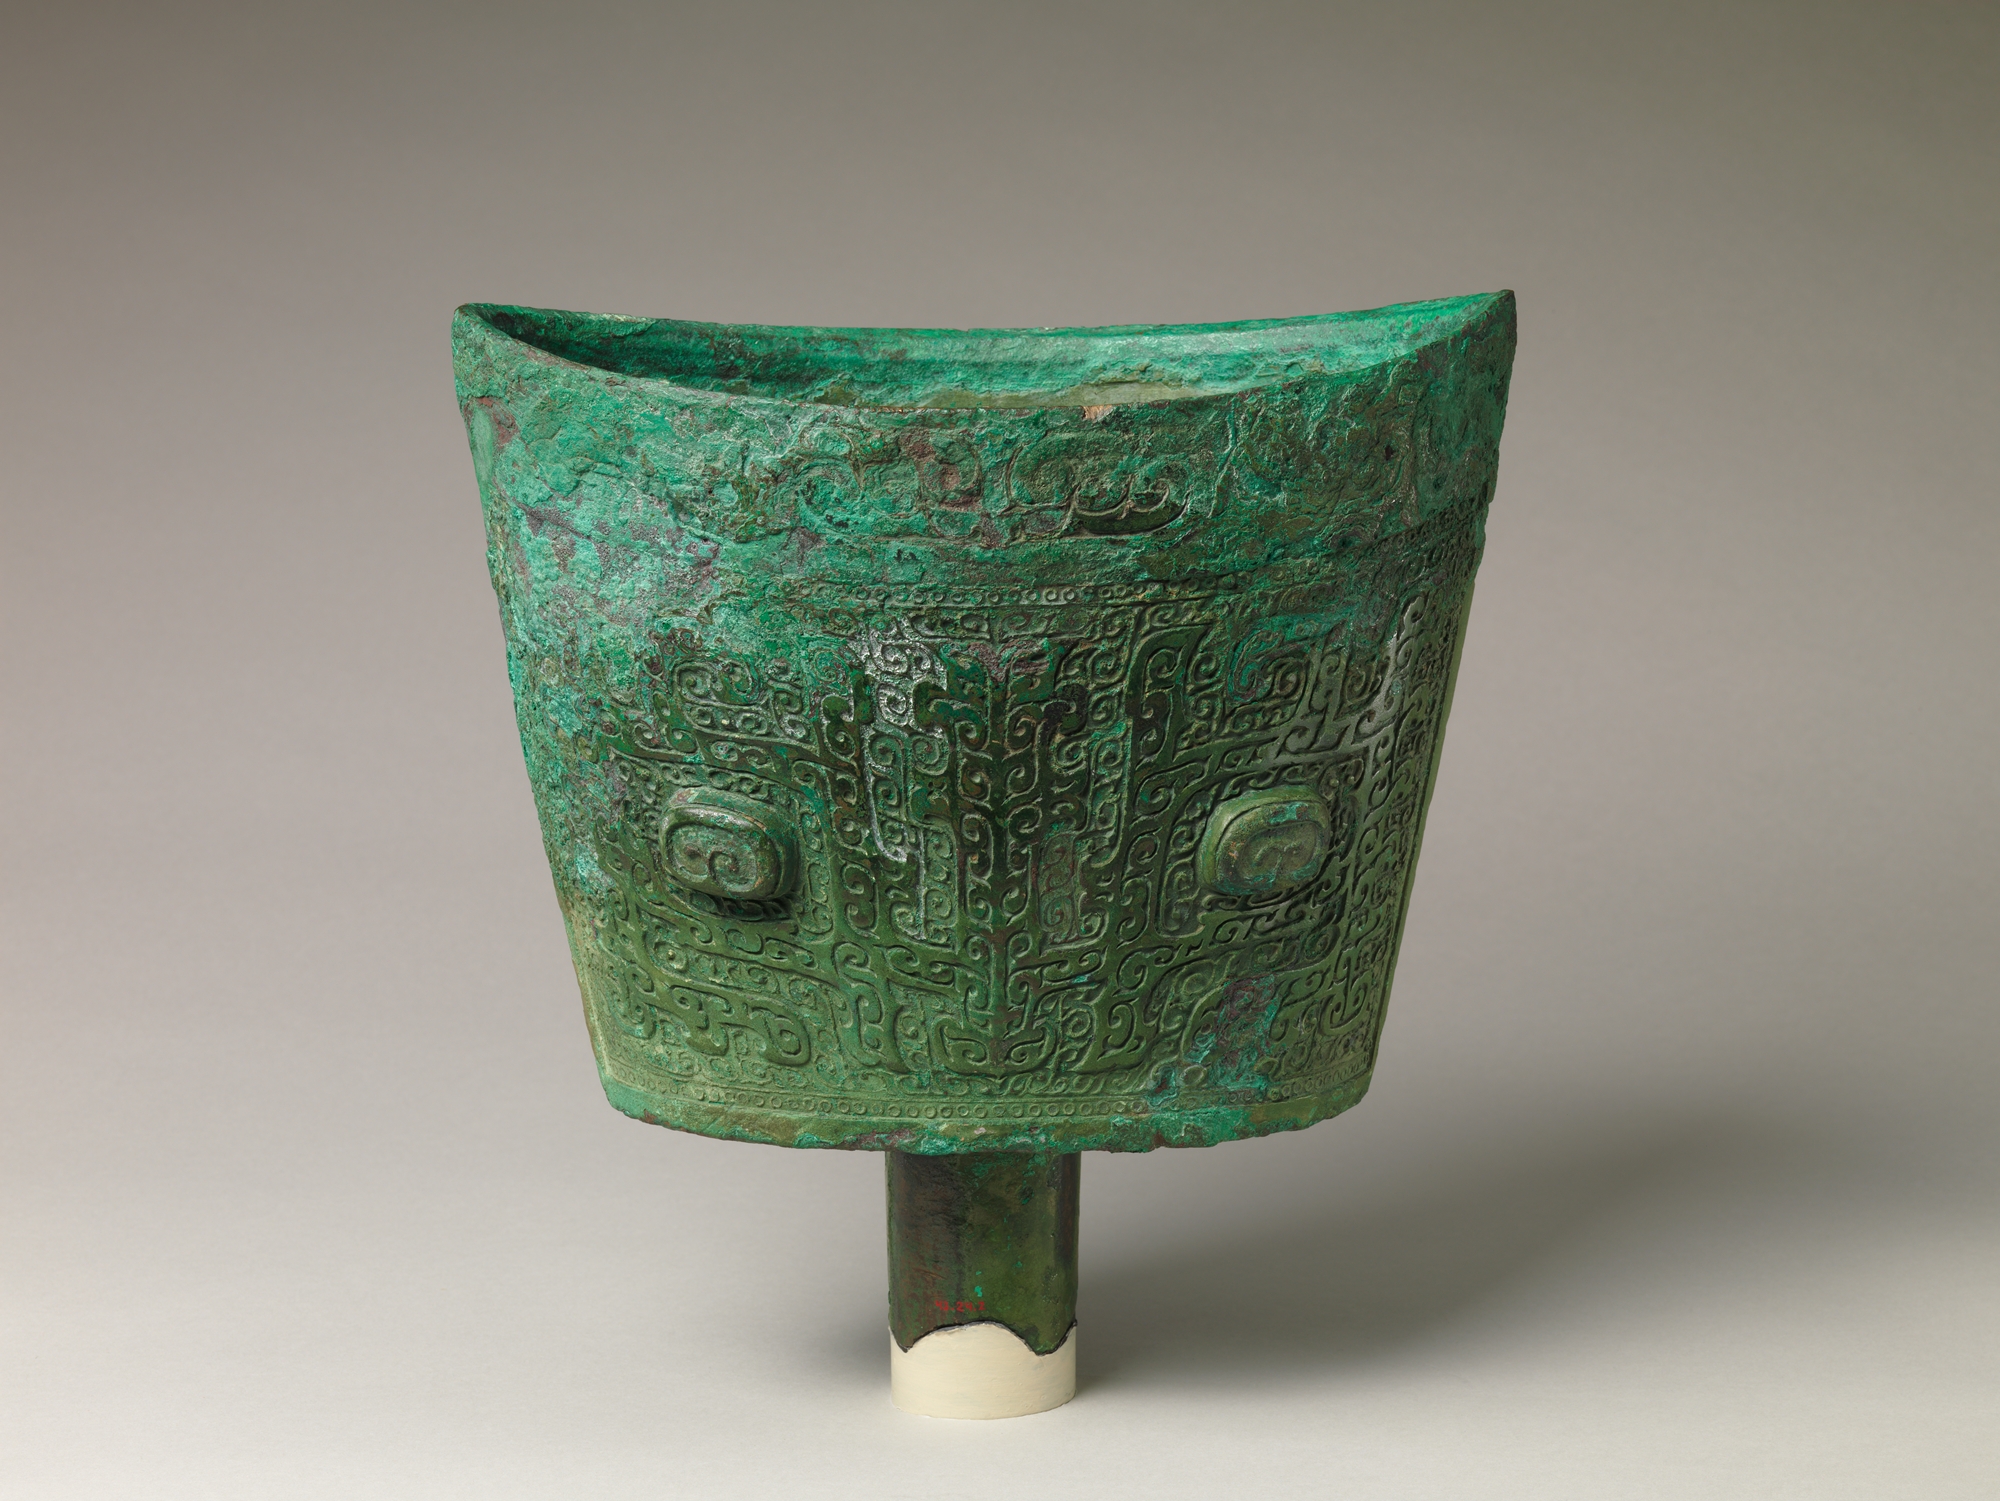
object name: bell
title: Upright bell (nao)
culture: chinese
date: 1300-1201 BCE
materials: bronze